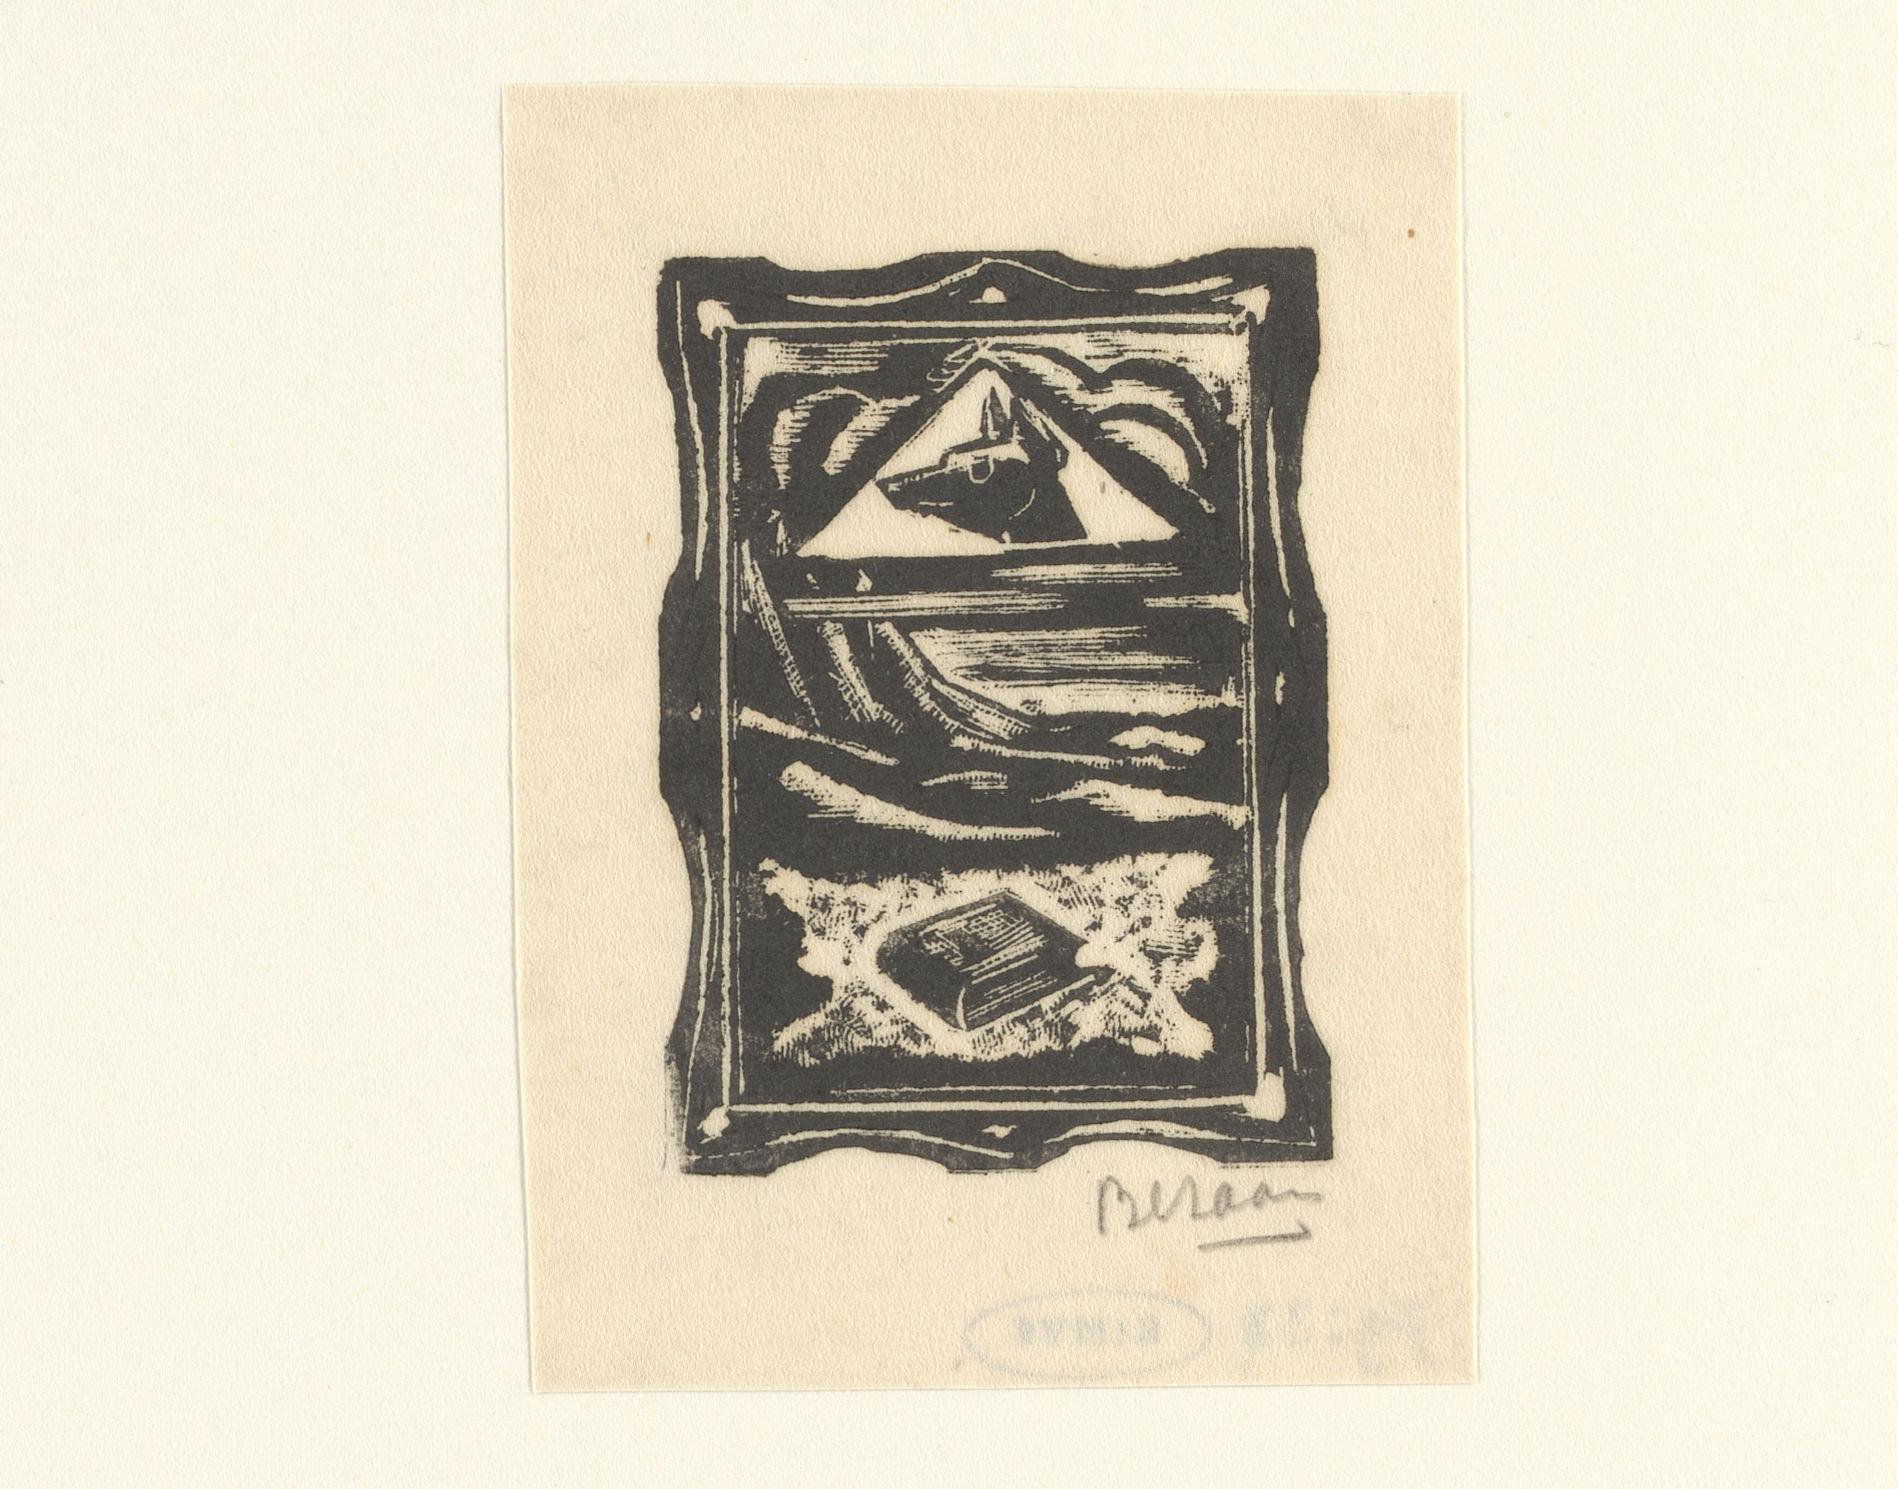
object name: print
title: Boek op een dierenvel met daarboven een hondenkop in een driehoek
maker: jo bezaan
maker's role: draughtsman, print maker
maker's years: 1894-1952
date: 1946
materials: paper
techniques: woodcut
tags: carpet, rug, book, dog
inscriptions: collector's mark: Lugt 2228